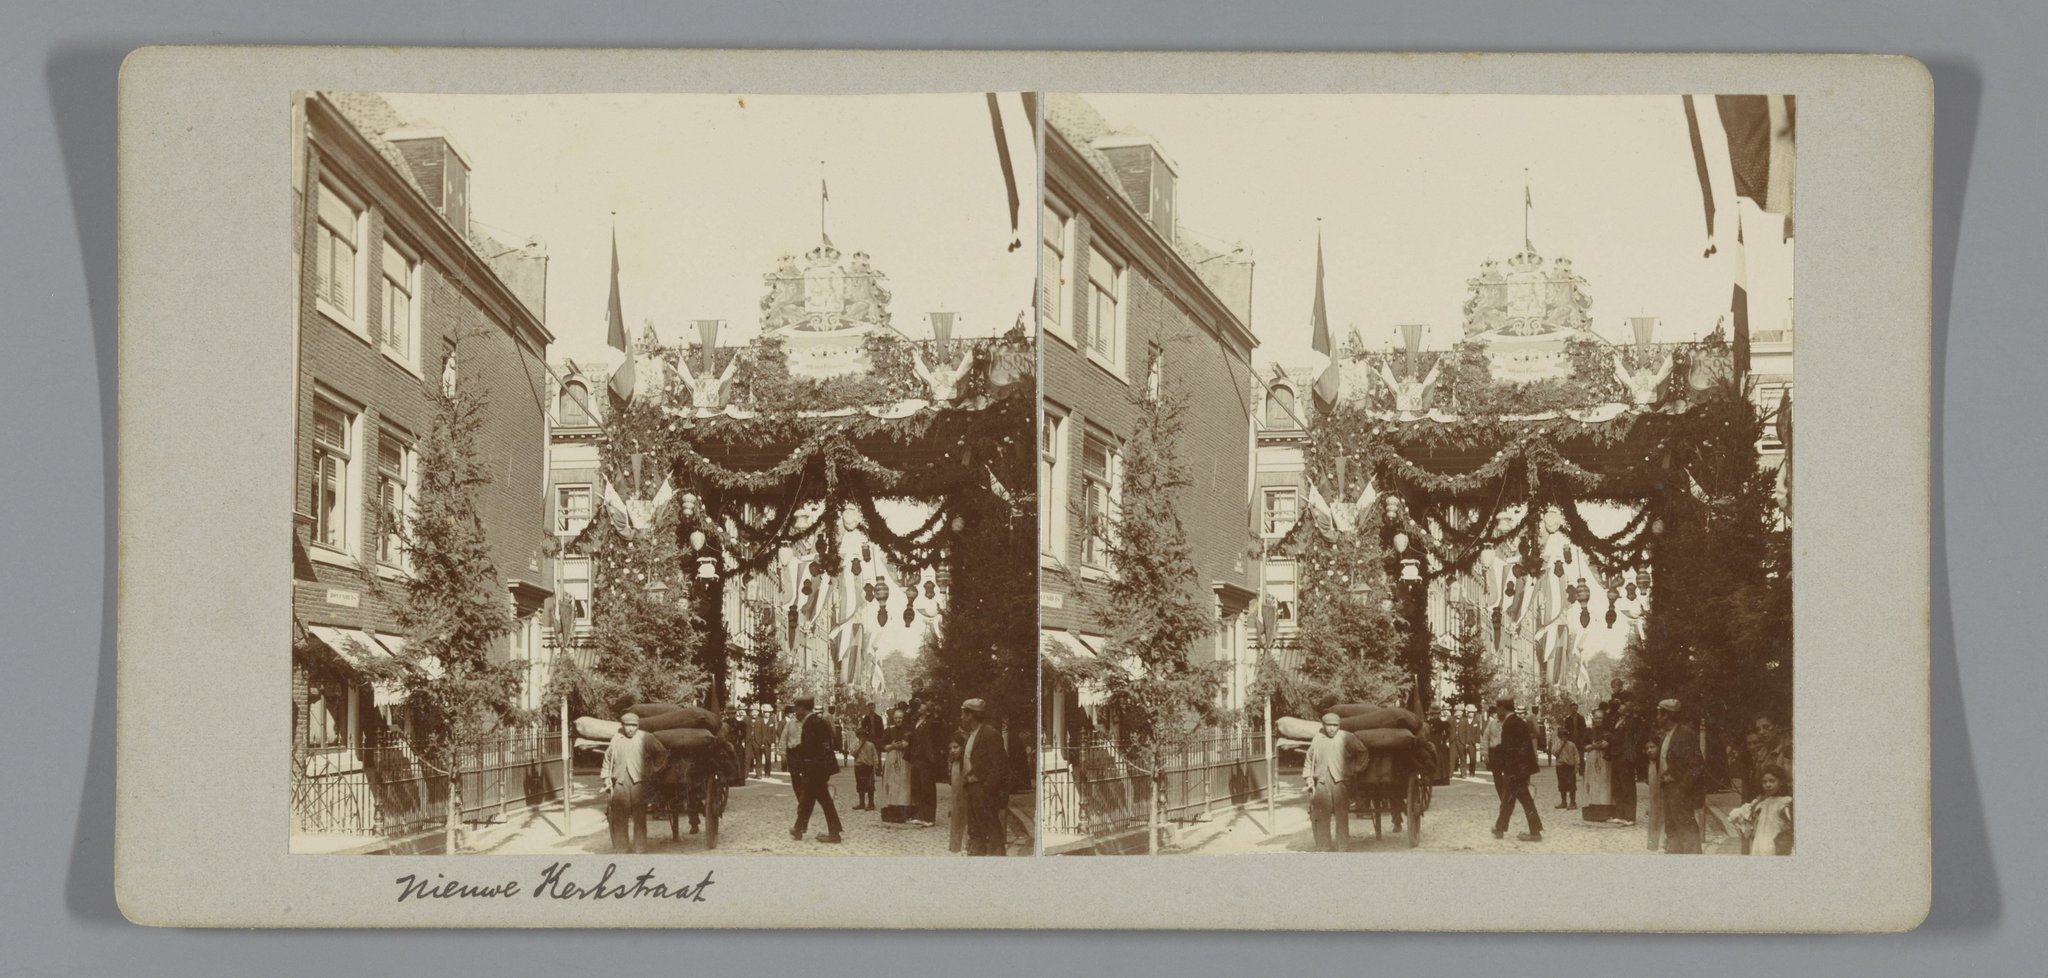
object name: stereograph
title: Nieuwe Kerkstraat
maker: Anonymous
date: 1898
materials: paper, cardboard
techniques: gelatin silver print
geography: amsterdam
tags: the hague, wilhelmina of the netherlands, gate, entrance, amsterdam